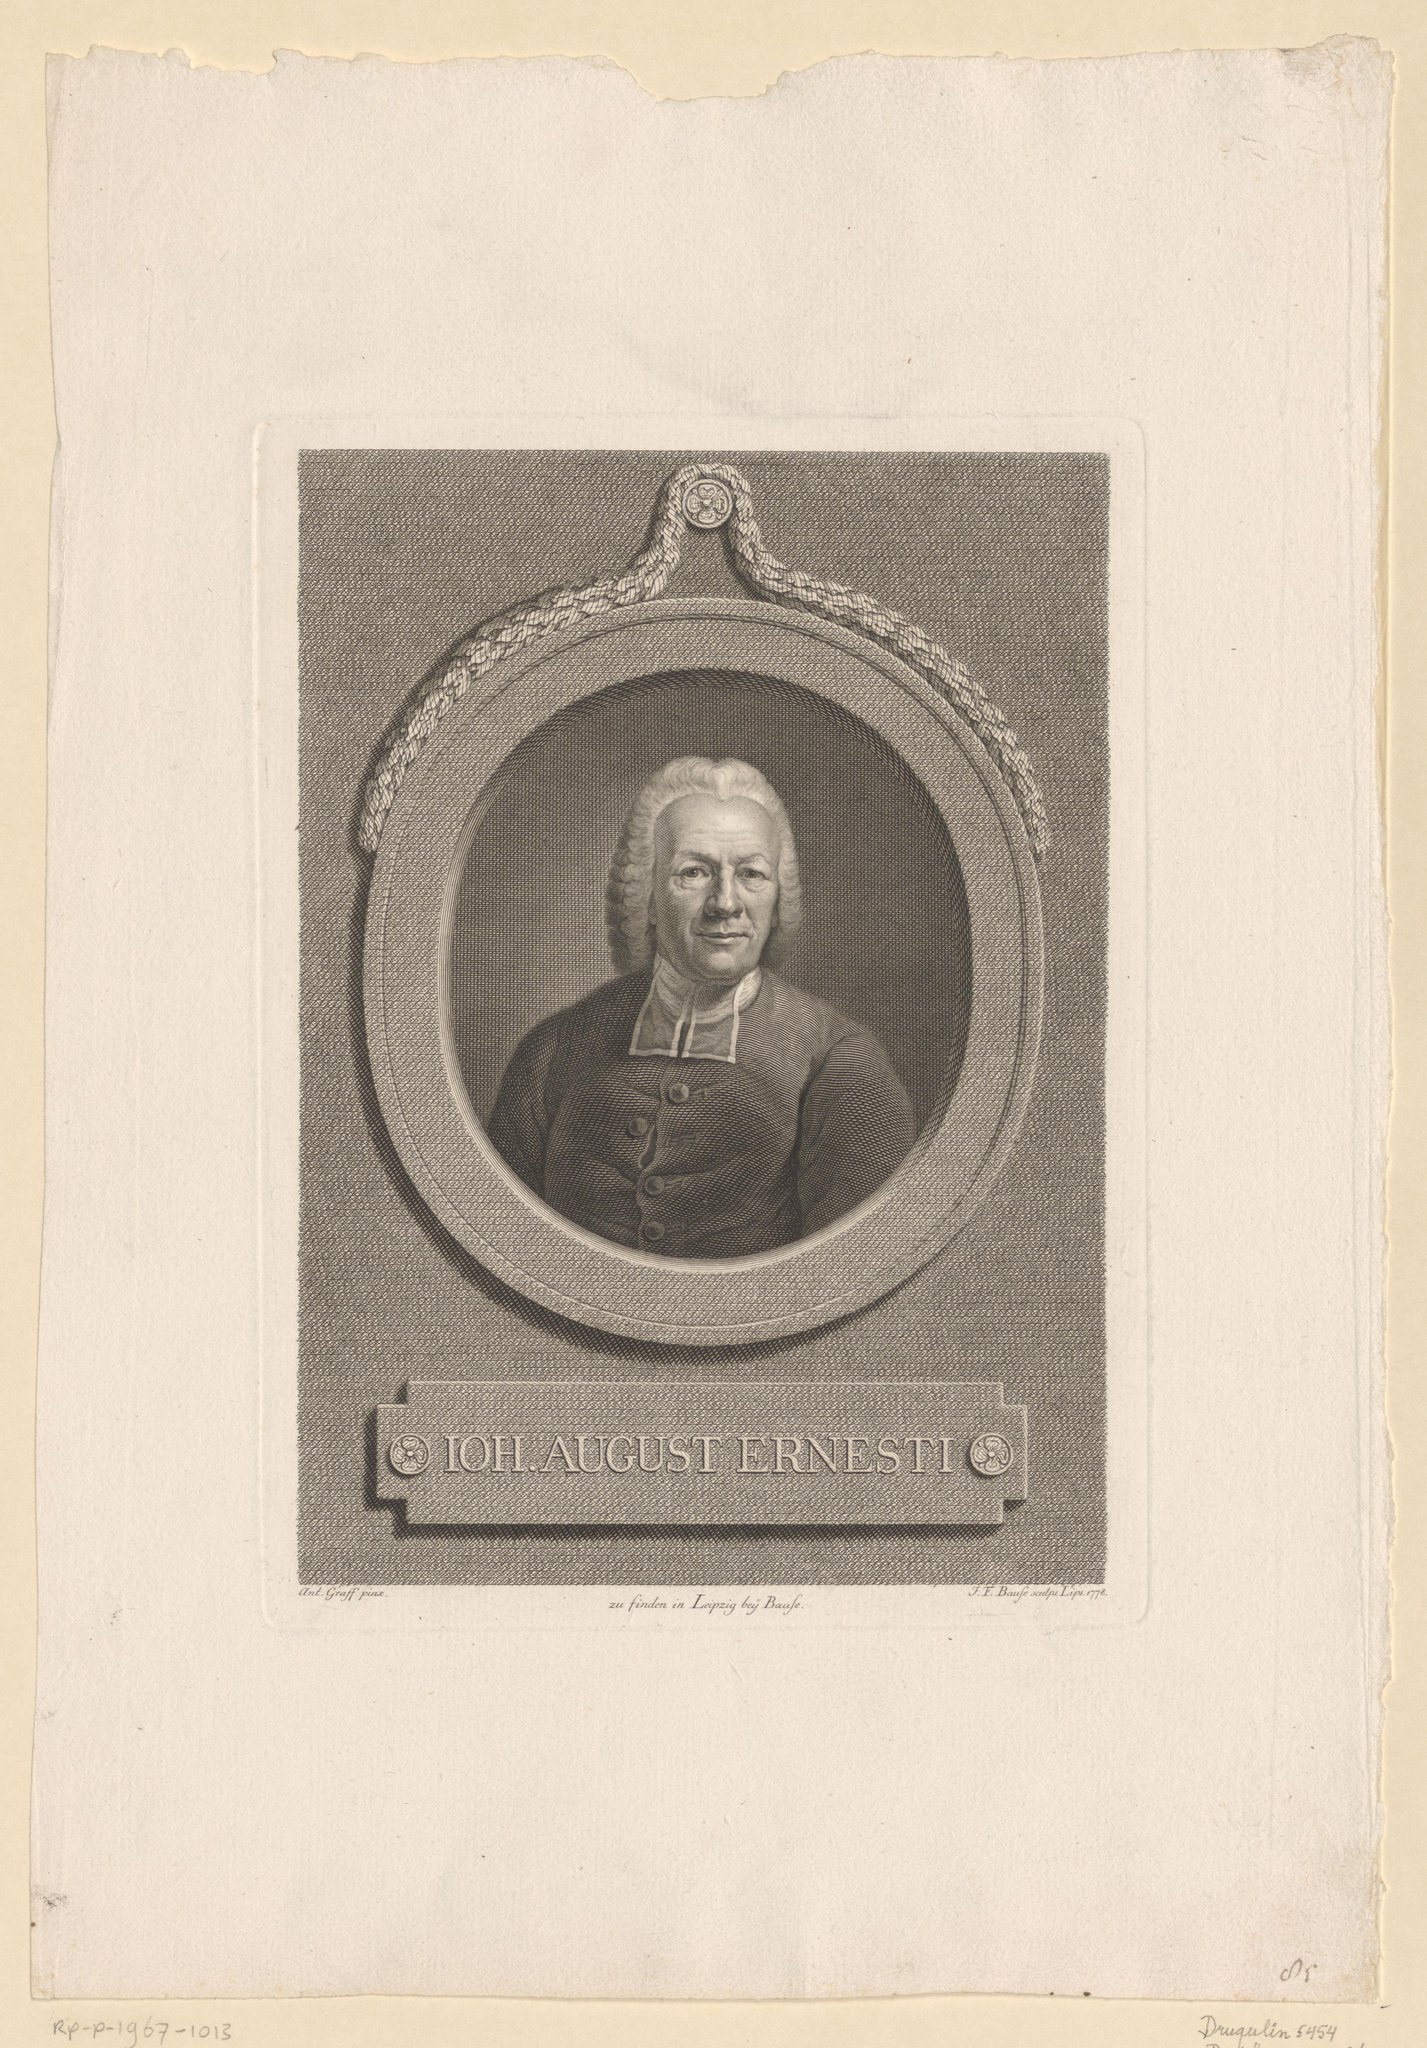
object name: print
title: Portret van Johann August Ernesti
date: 1778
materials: paper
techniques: engraving, etching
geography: leipzig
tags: theologian, ornament ~ medallion, historical persons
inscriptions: collector's mark: Lugt 2228, number: ‘85’